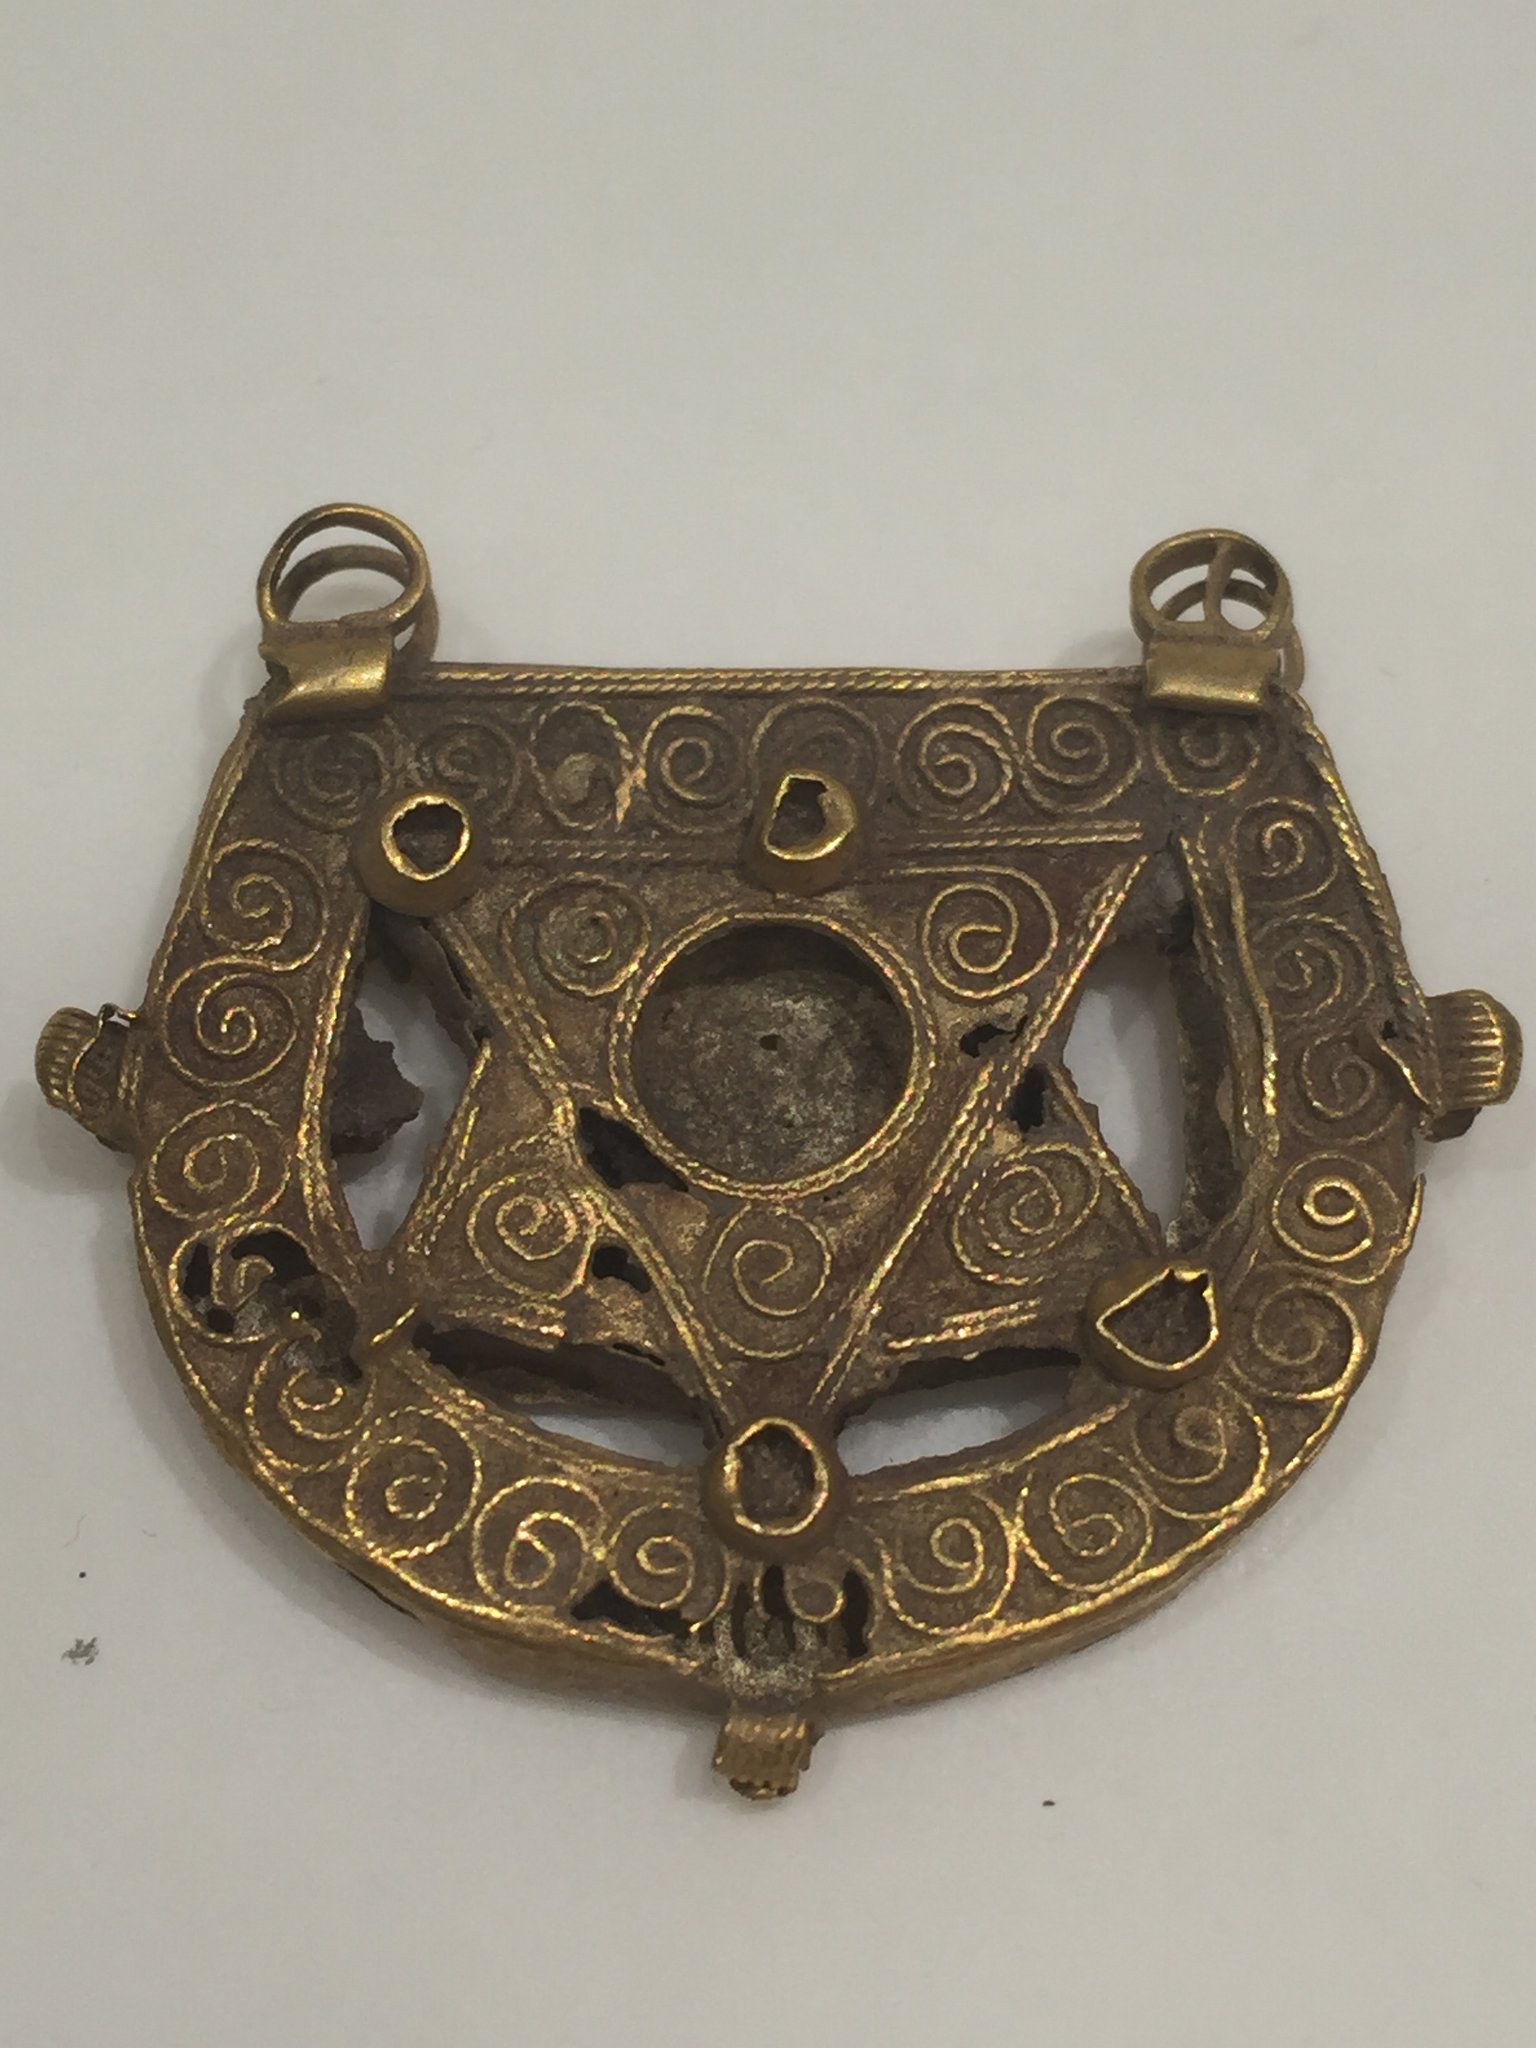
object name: earring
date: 1001-1300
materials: gold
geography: iraq